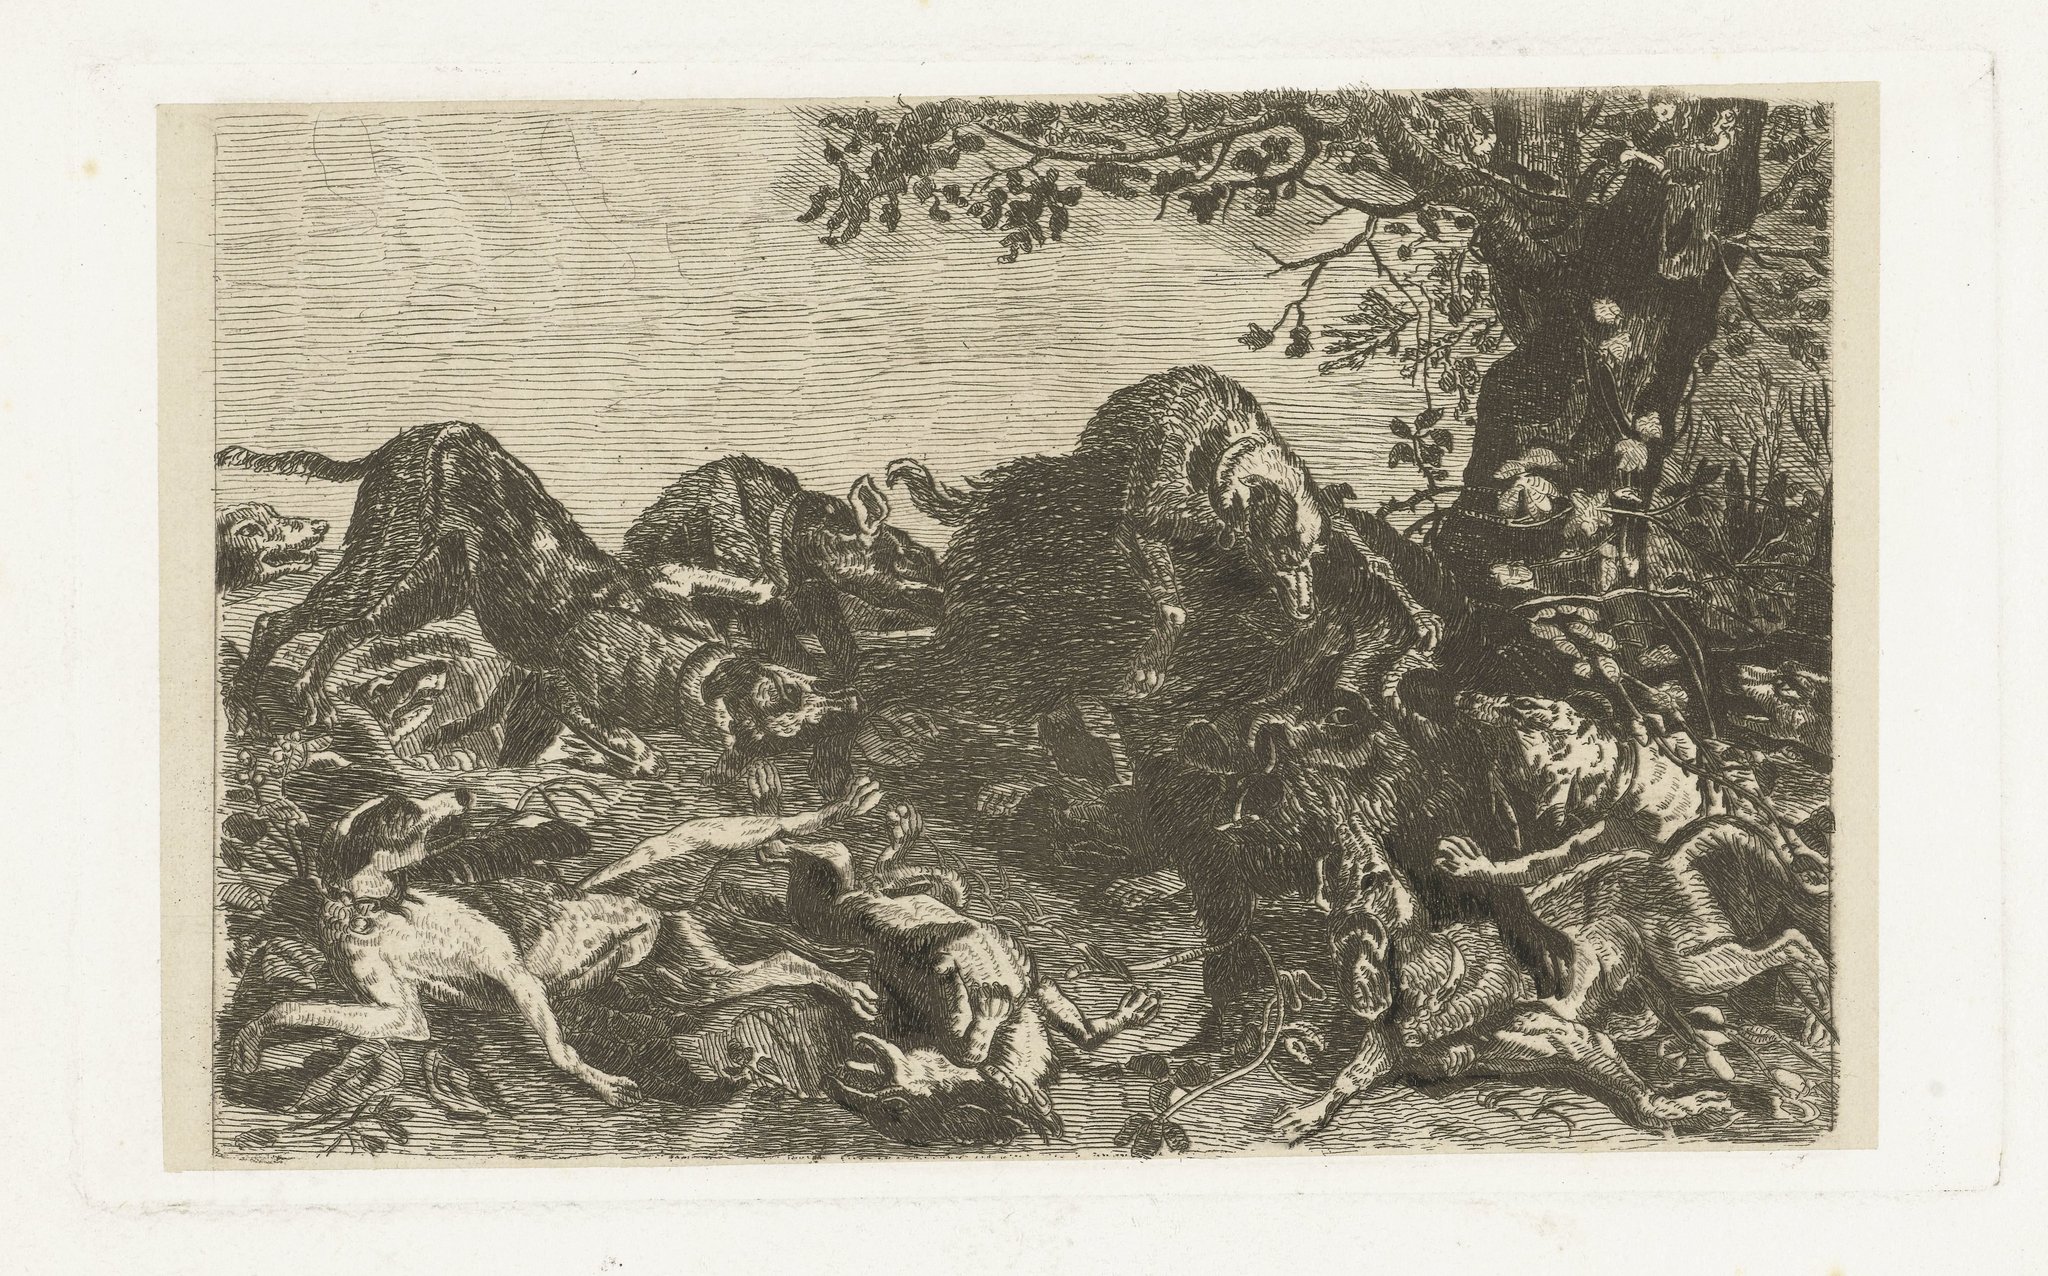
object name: print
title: Hondenjacht op een everzwijn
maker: jan cassiers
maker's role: print maker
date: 1700-1800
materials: paper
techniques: etching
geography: antwerp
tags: boar (male pig), hunting dogs, boar-hunting, sports, games ~ animals (+ hunting with dogs)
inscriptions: collector's mark: Lugt 2228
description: Jachthonden vallen een everzwijn aan. Het zwijn probeert zich te verdedigen maar de honden hebben het omsingeld.